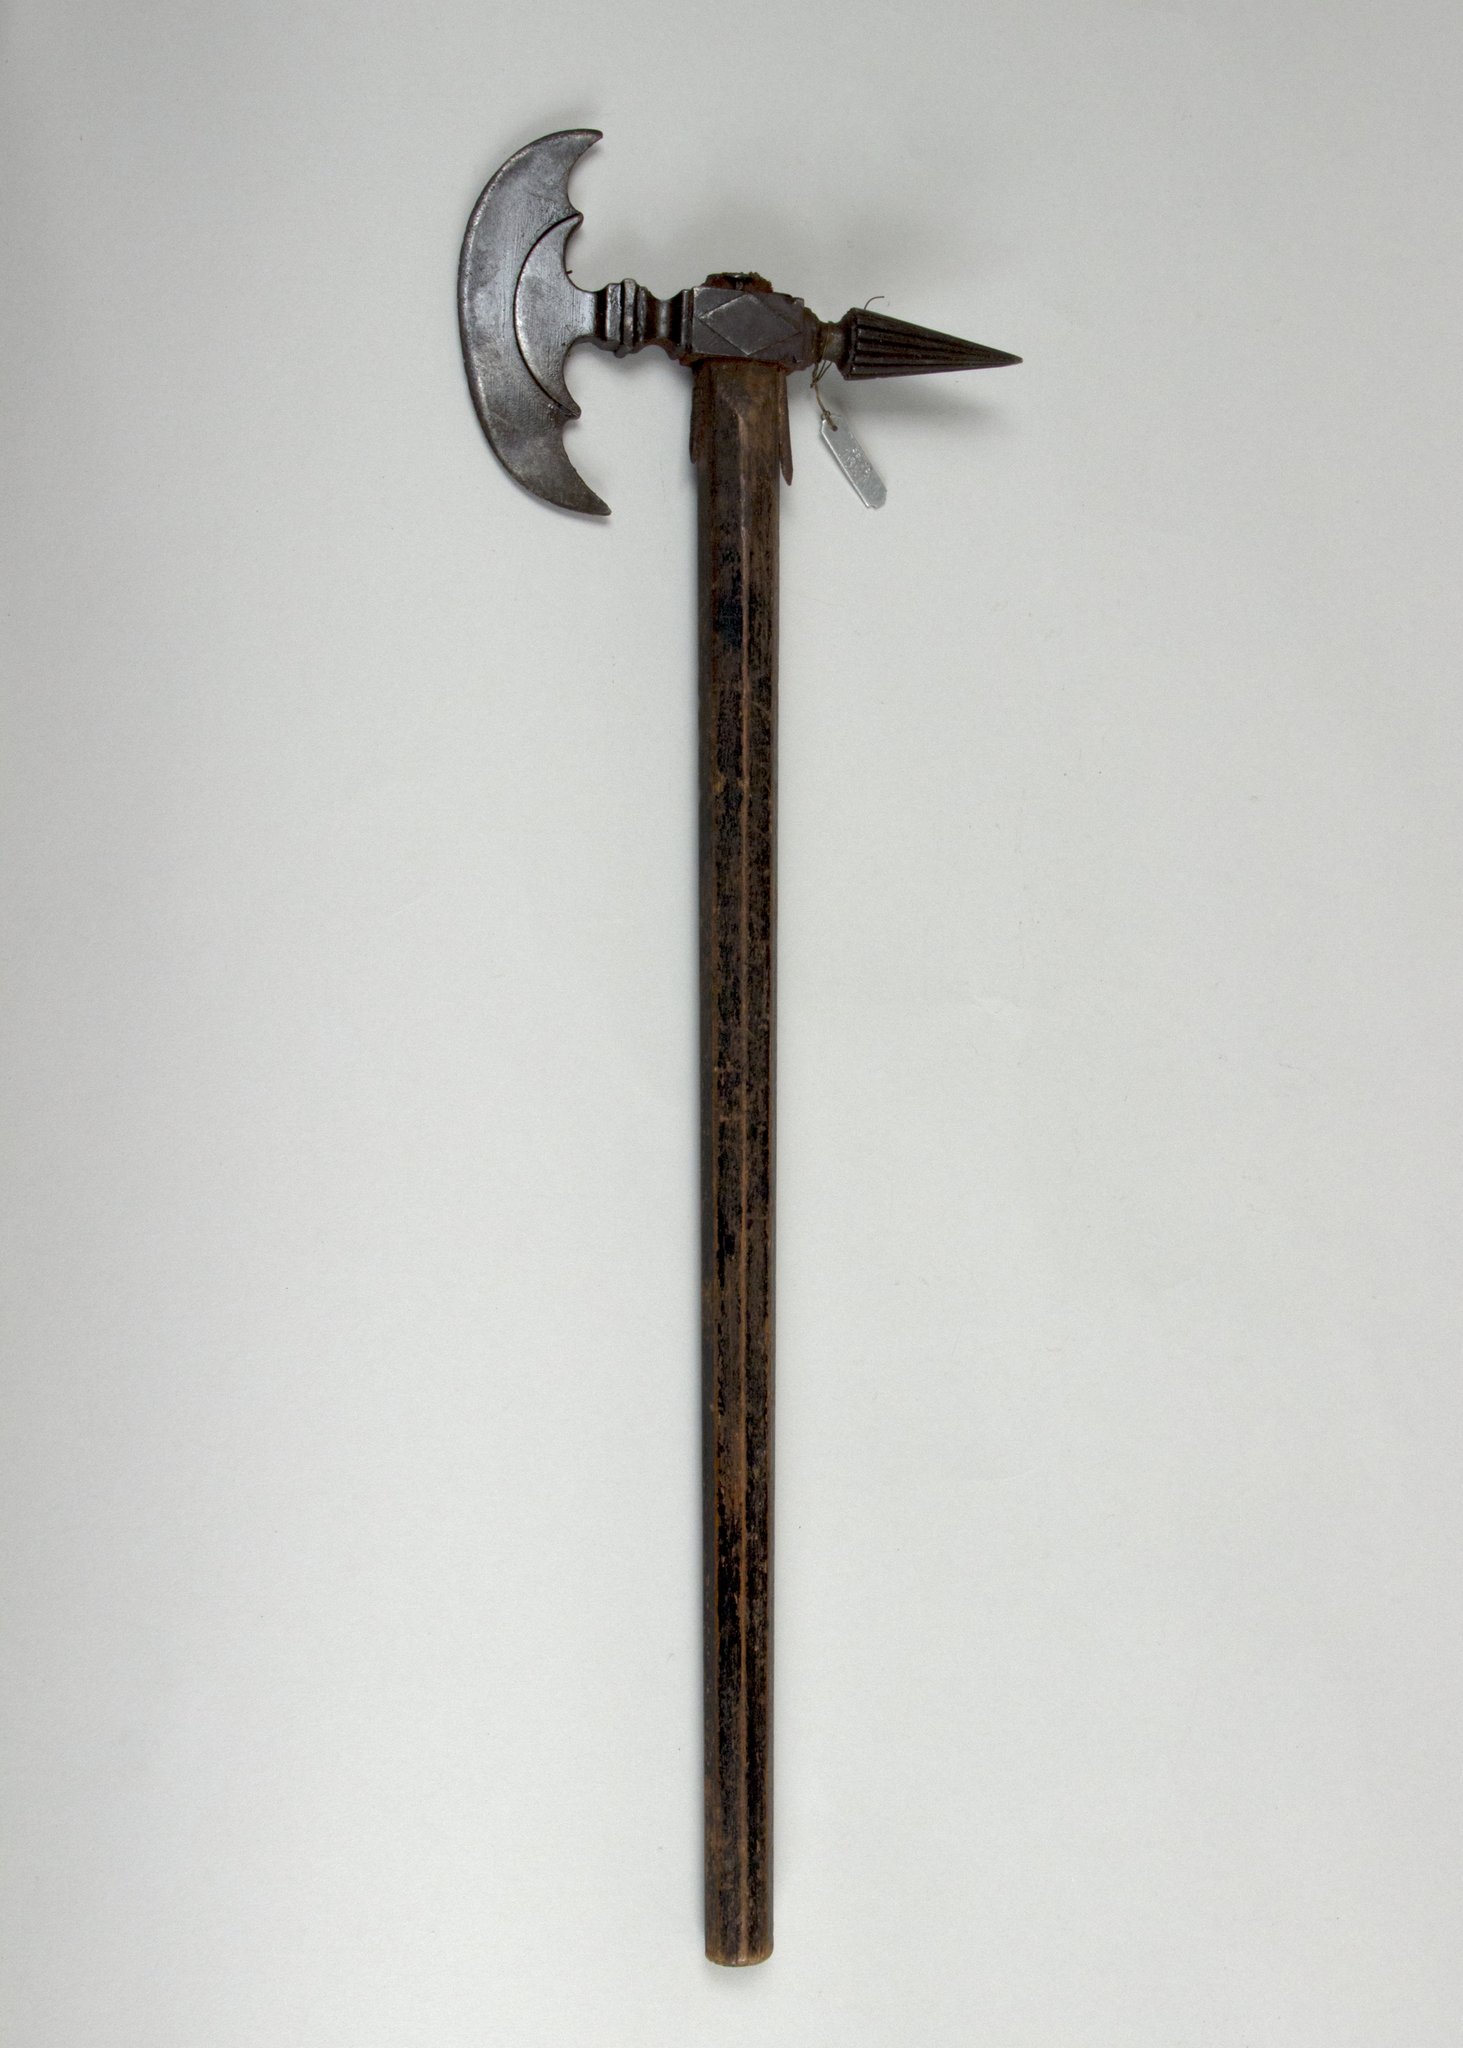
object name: axe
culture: turkish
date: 1801-1900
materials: steel, wood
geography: ottoman empire